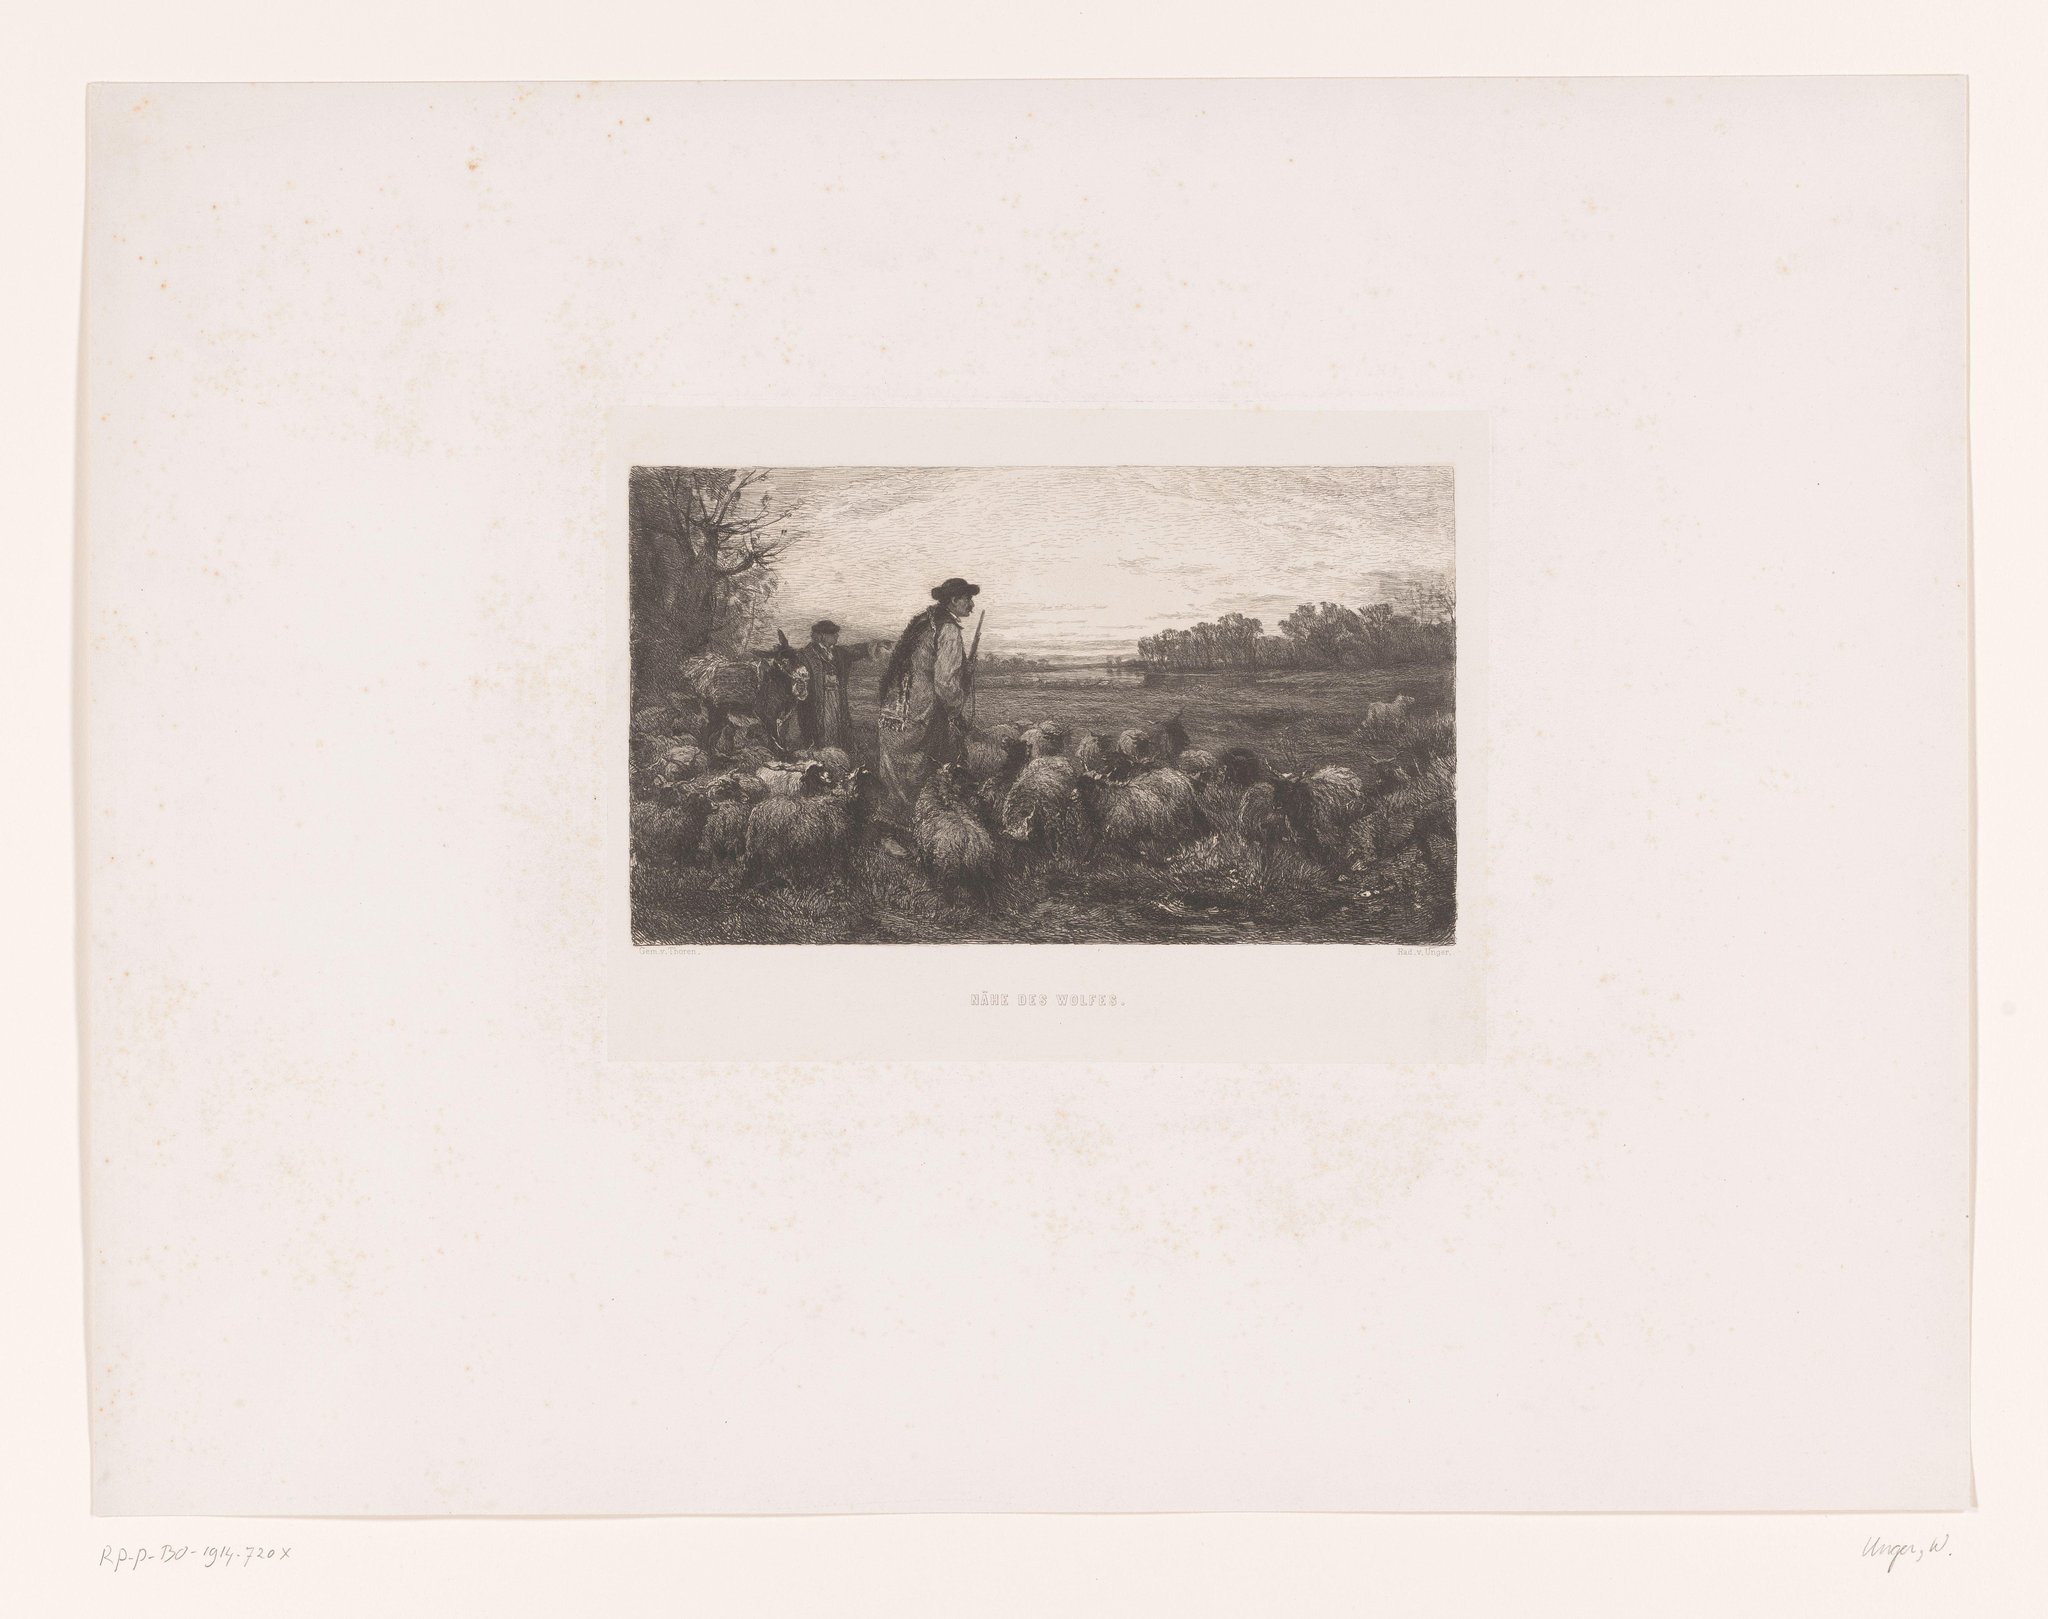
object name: print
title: Nähe des Wolfes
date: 1847-1889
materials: paper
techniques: etching, intaglio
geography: germany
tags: herding, herdsman, herdswoman, shepherd, shepherdess, cowherd, etc., sheep, beasts of prey, predatory animals: wolf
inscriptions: collector's mark: Lugt 2233